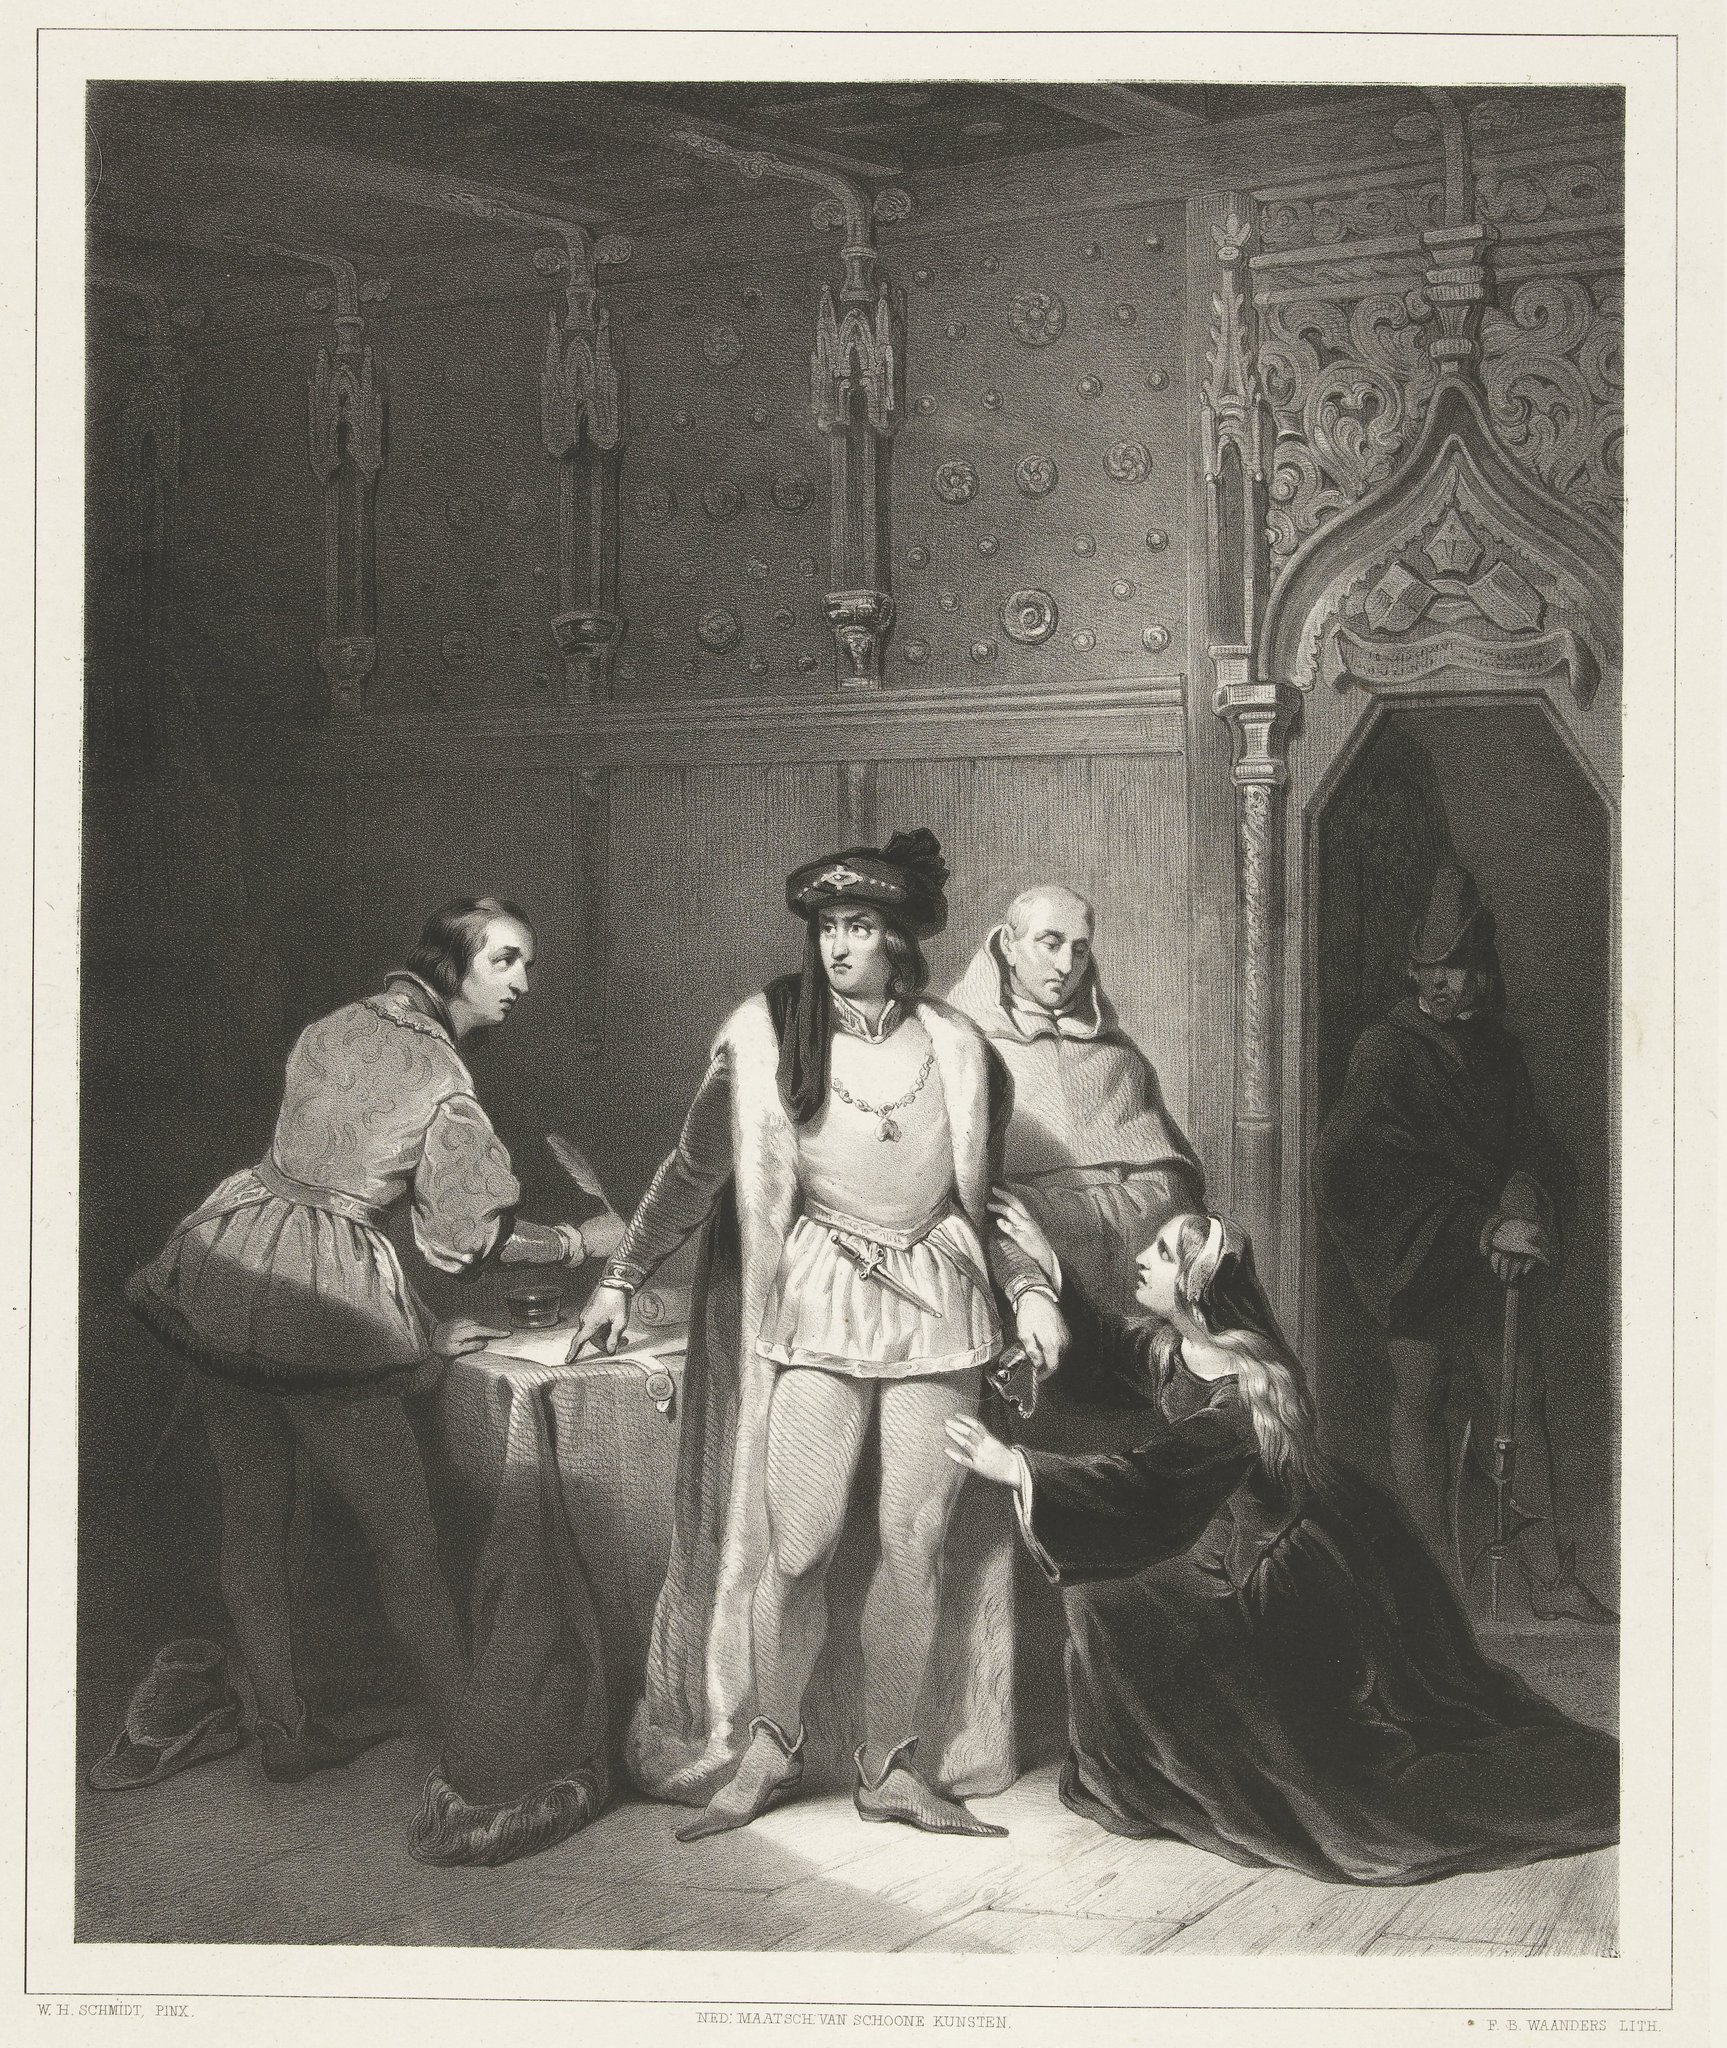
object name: history print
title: De gouverneur van Zeeland en Saphira, ca. 1474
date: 1841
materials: paper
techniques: lithograph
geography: netherlands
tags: earl, charles the bold (duke of burgundy), law and jurisprudence (+ condemnation or punishment of the guiltless), netherlands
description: De gouverneur van Zeeland (of Gelderland) laat het doodsvonnis van de man (P. Stalins) van Saphira ondertekenen. Saphira knielt smekend voor de gouverneur. Scène uit het verhaal van de rechtspraak van Karel de Stoute over de gouverneur van Zeeland, ca. 1474. Ook bekend als het verhaal van Rhynsault en Saphira.